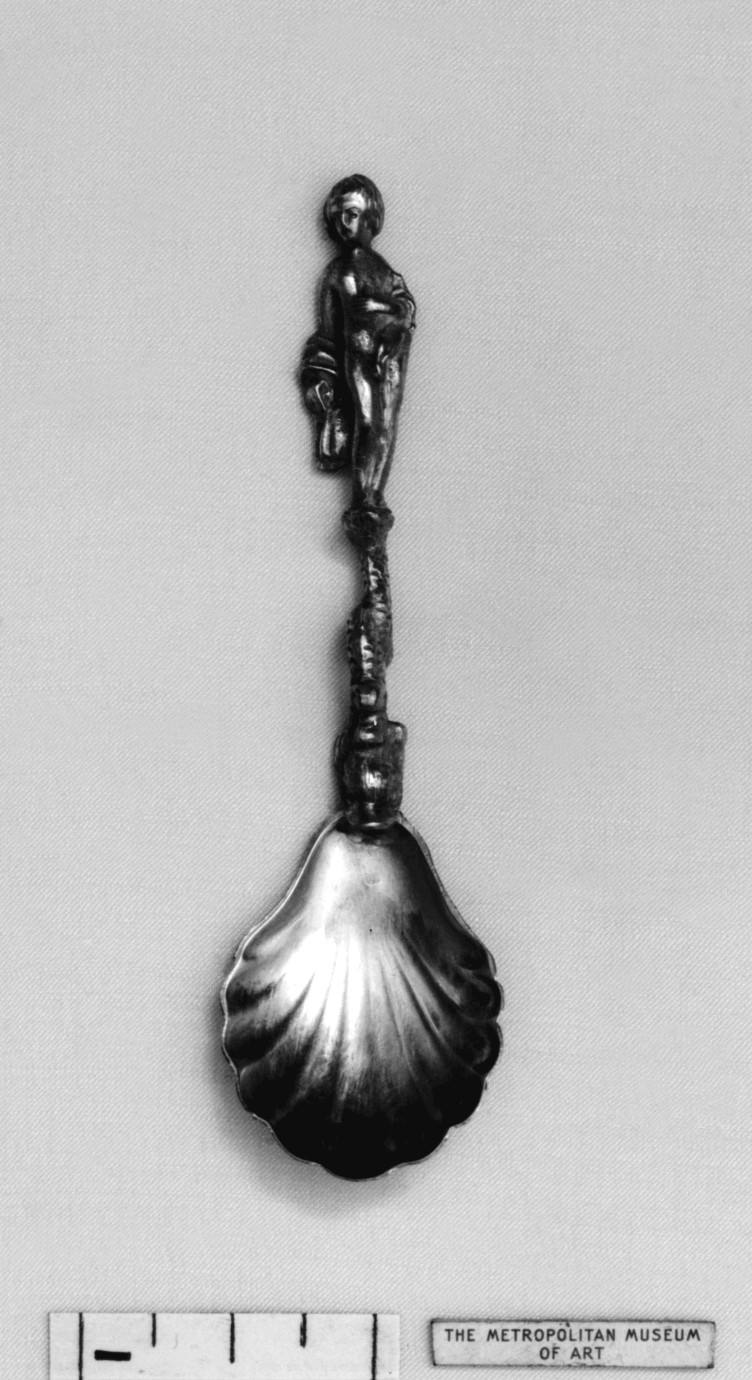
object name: salt spoon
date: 1801-1900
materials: gilt, silver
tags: human figures